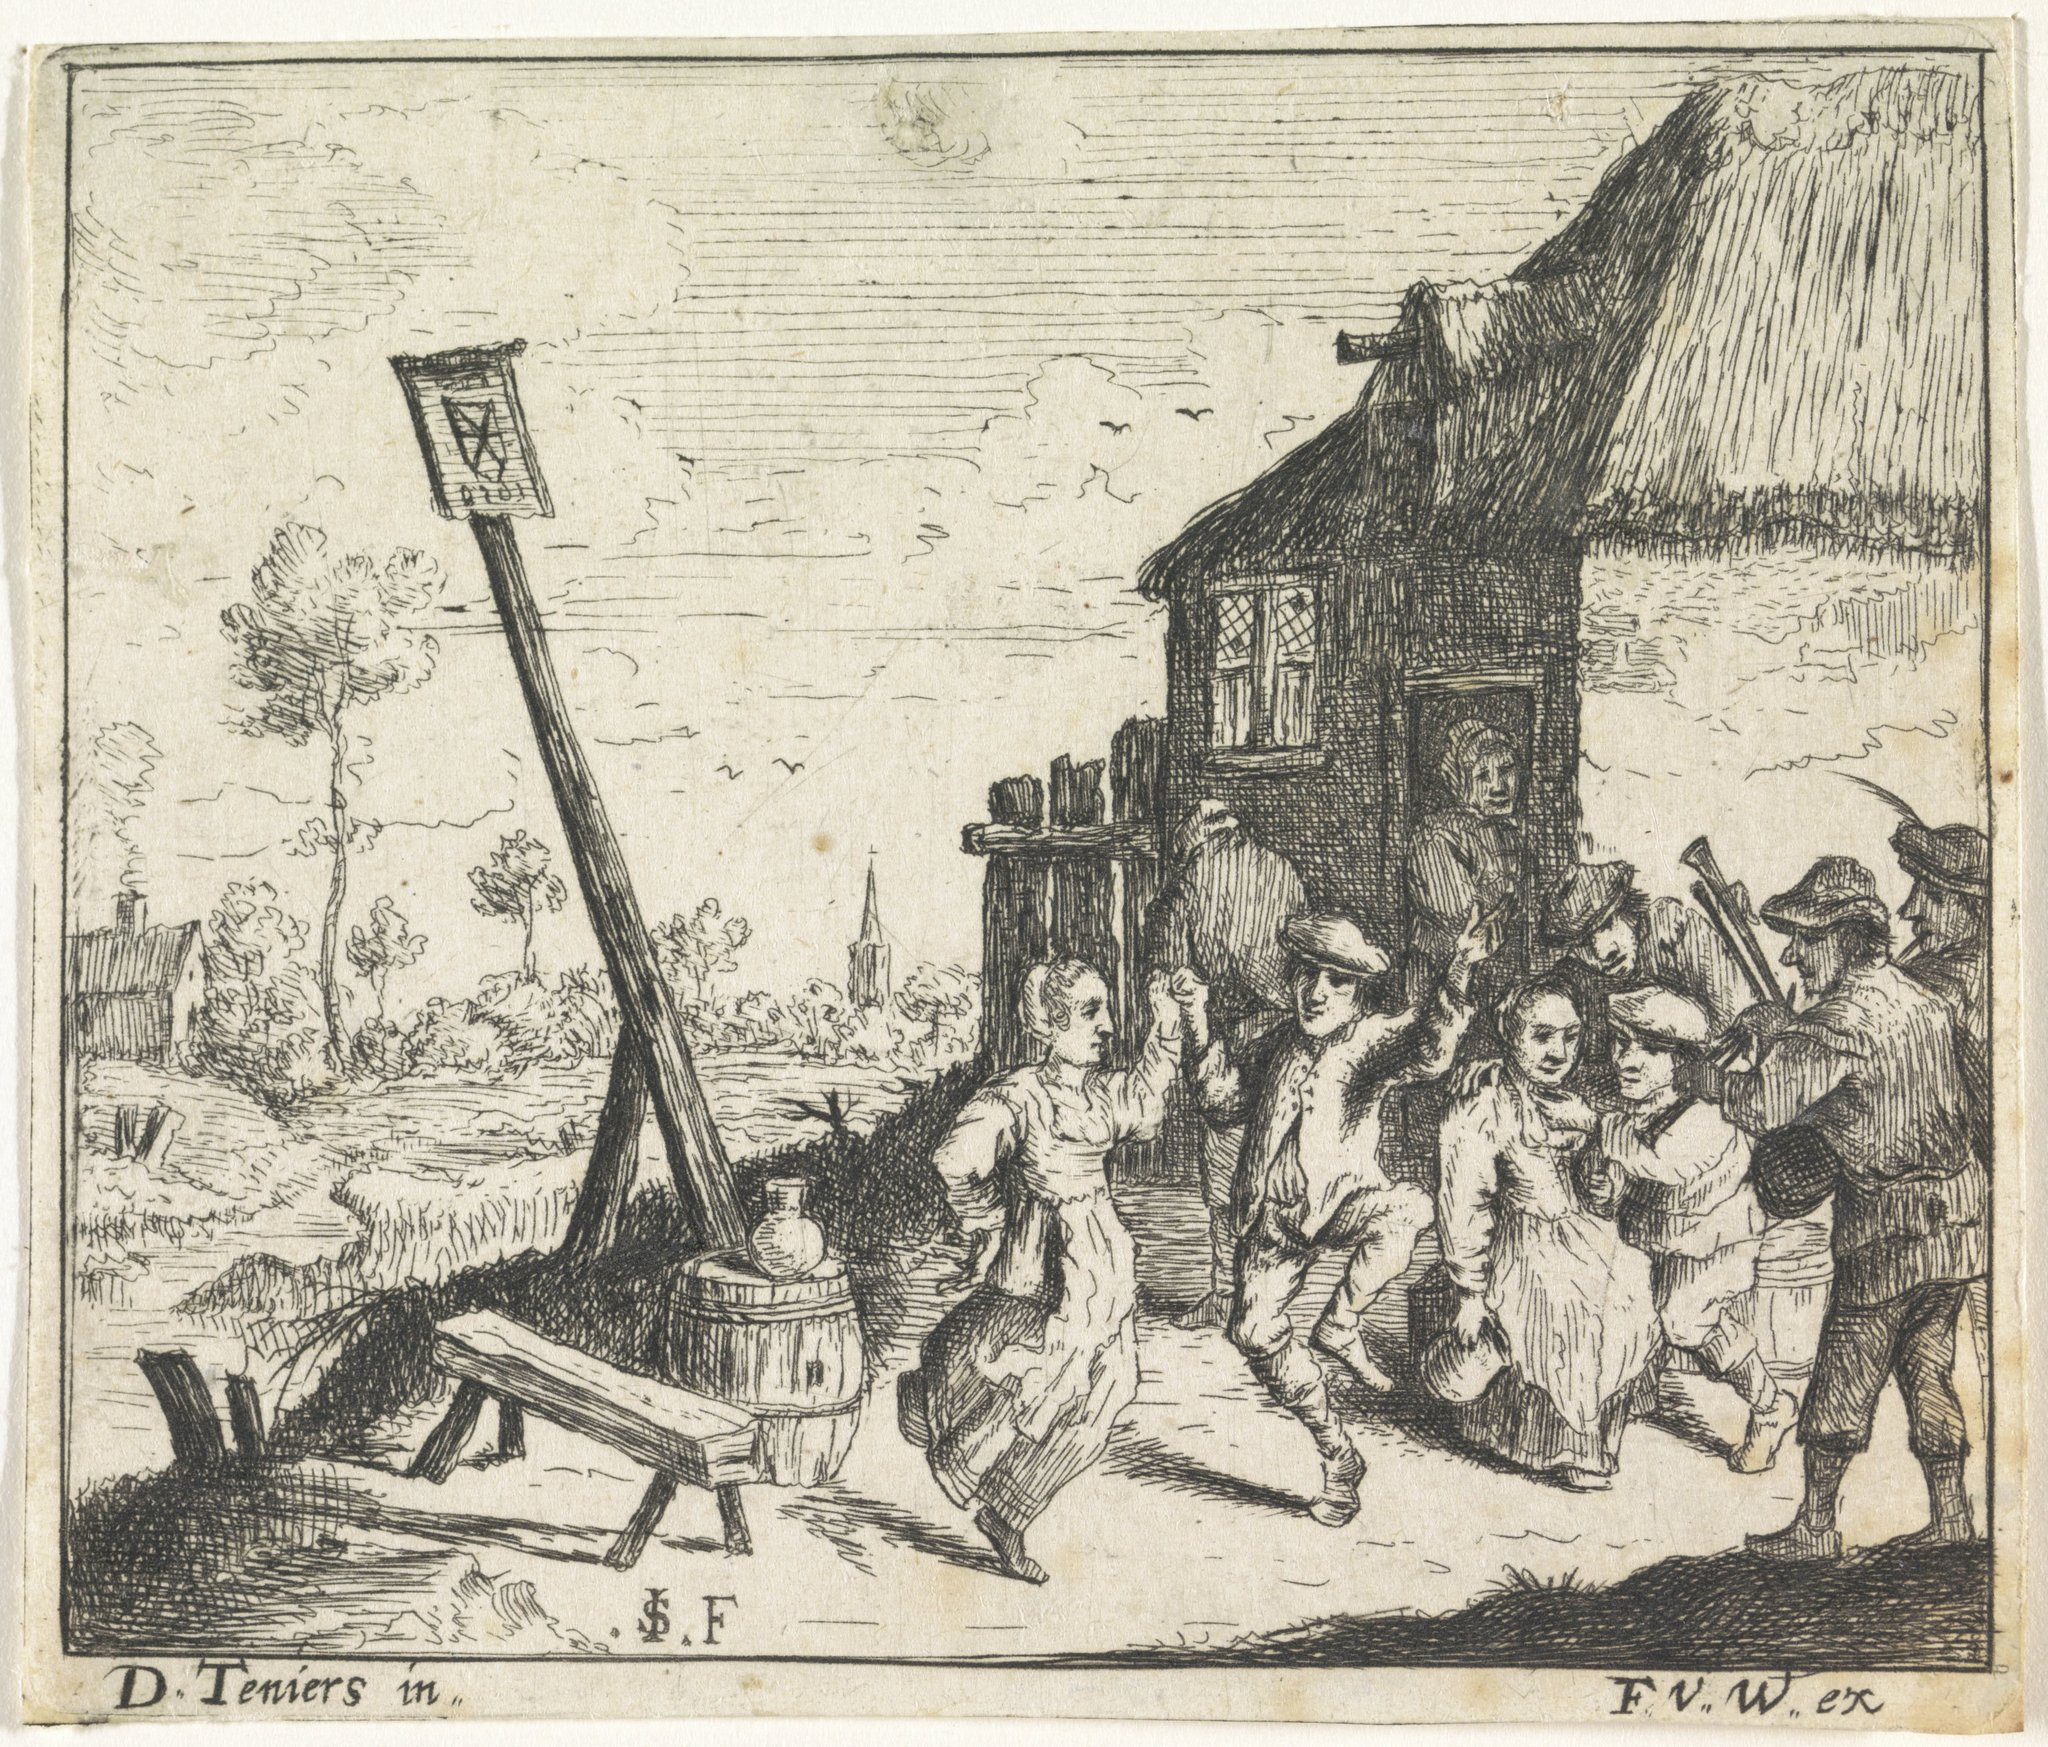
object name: print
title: Dans voor de herberg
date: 1624-1679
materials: paper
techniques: etching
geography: antwerp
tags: bagpipe, musette, one pair dancing; man and woman dancing as a couple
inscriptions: collector's mark: Lugt 240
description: Een paar danst voor een herberg op de muziek van een doedelzakspeler. Voor de herberg zitten drinkende boeren.